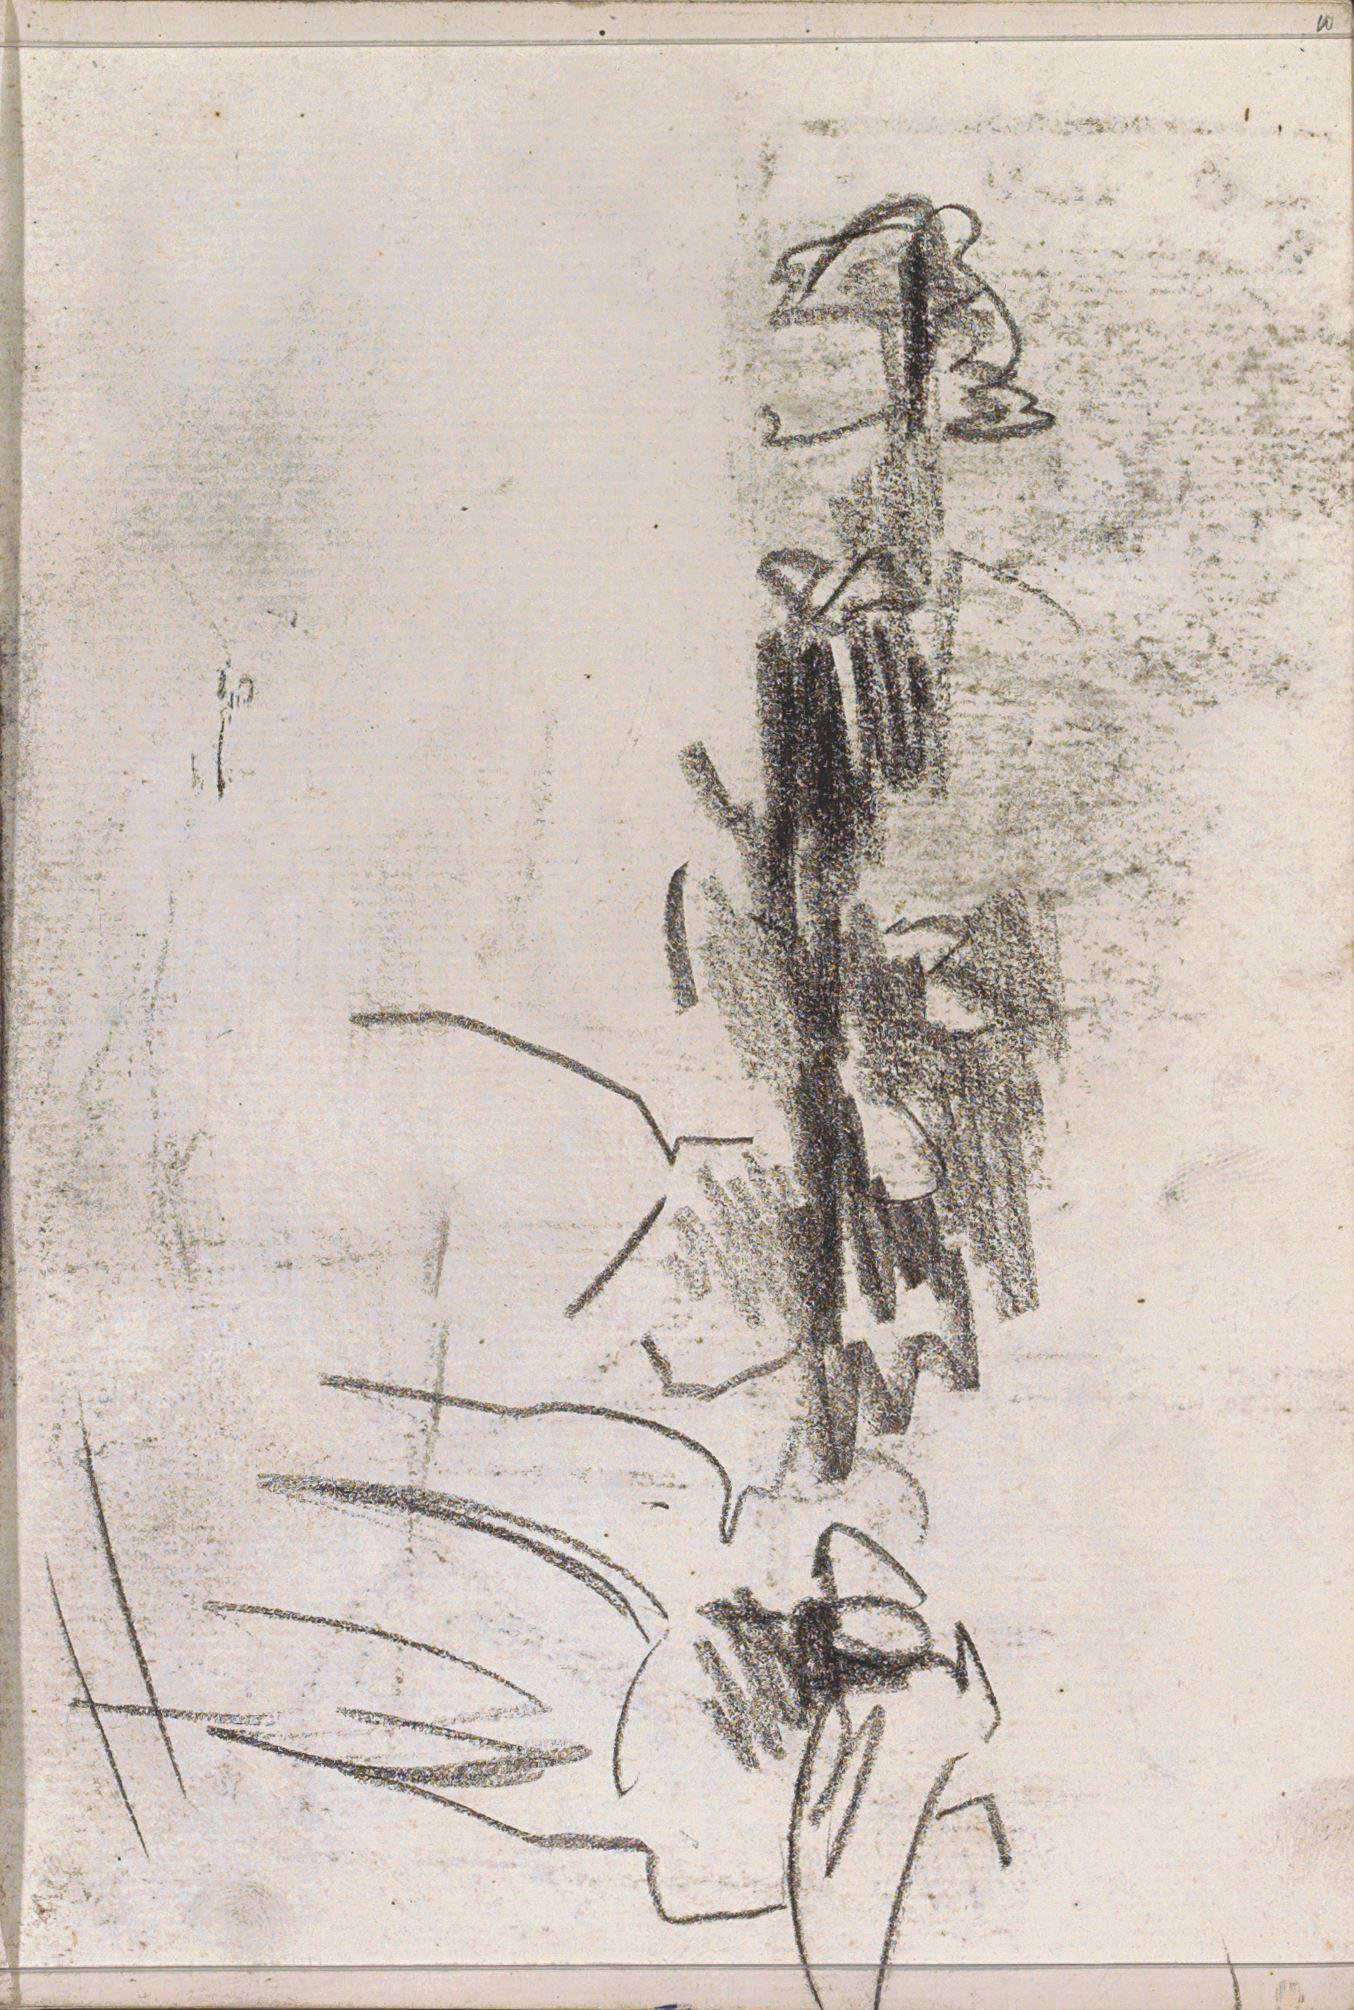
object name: sketchbook leaf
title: Studies, mogelijk figuurstudies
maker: isaac israels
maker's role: draughtsman, painter, print maker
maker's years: 1865-1934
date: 1875-1934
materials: chalk, paper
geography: the hague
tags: the (nude) human figure; 'corpo humano' (ripa)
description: Pagina 10 uit schetsboek XLIV met 43 pagina's.